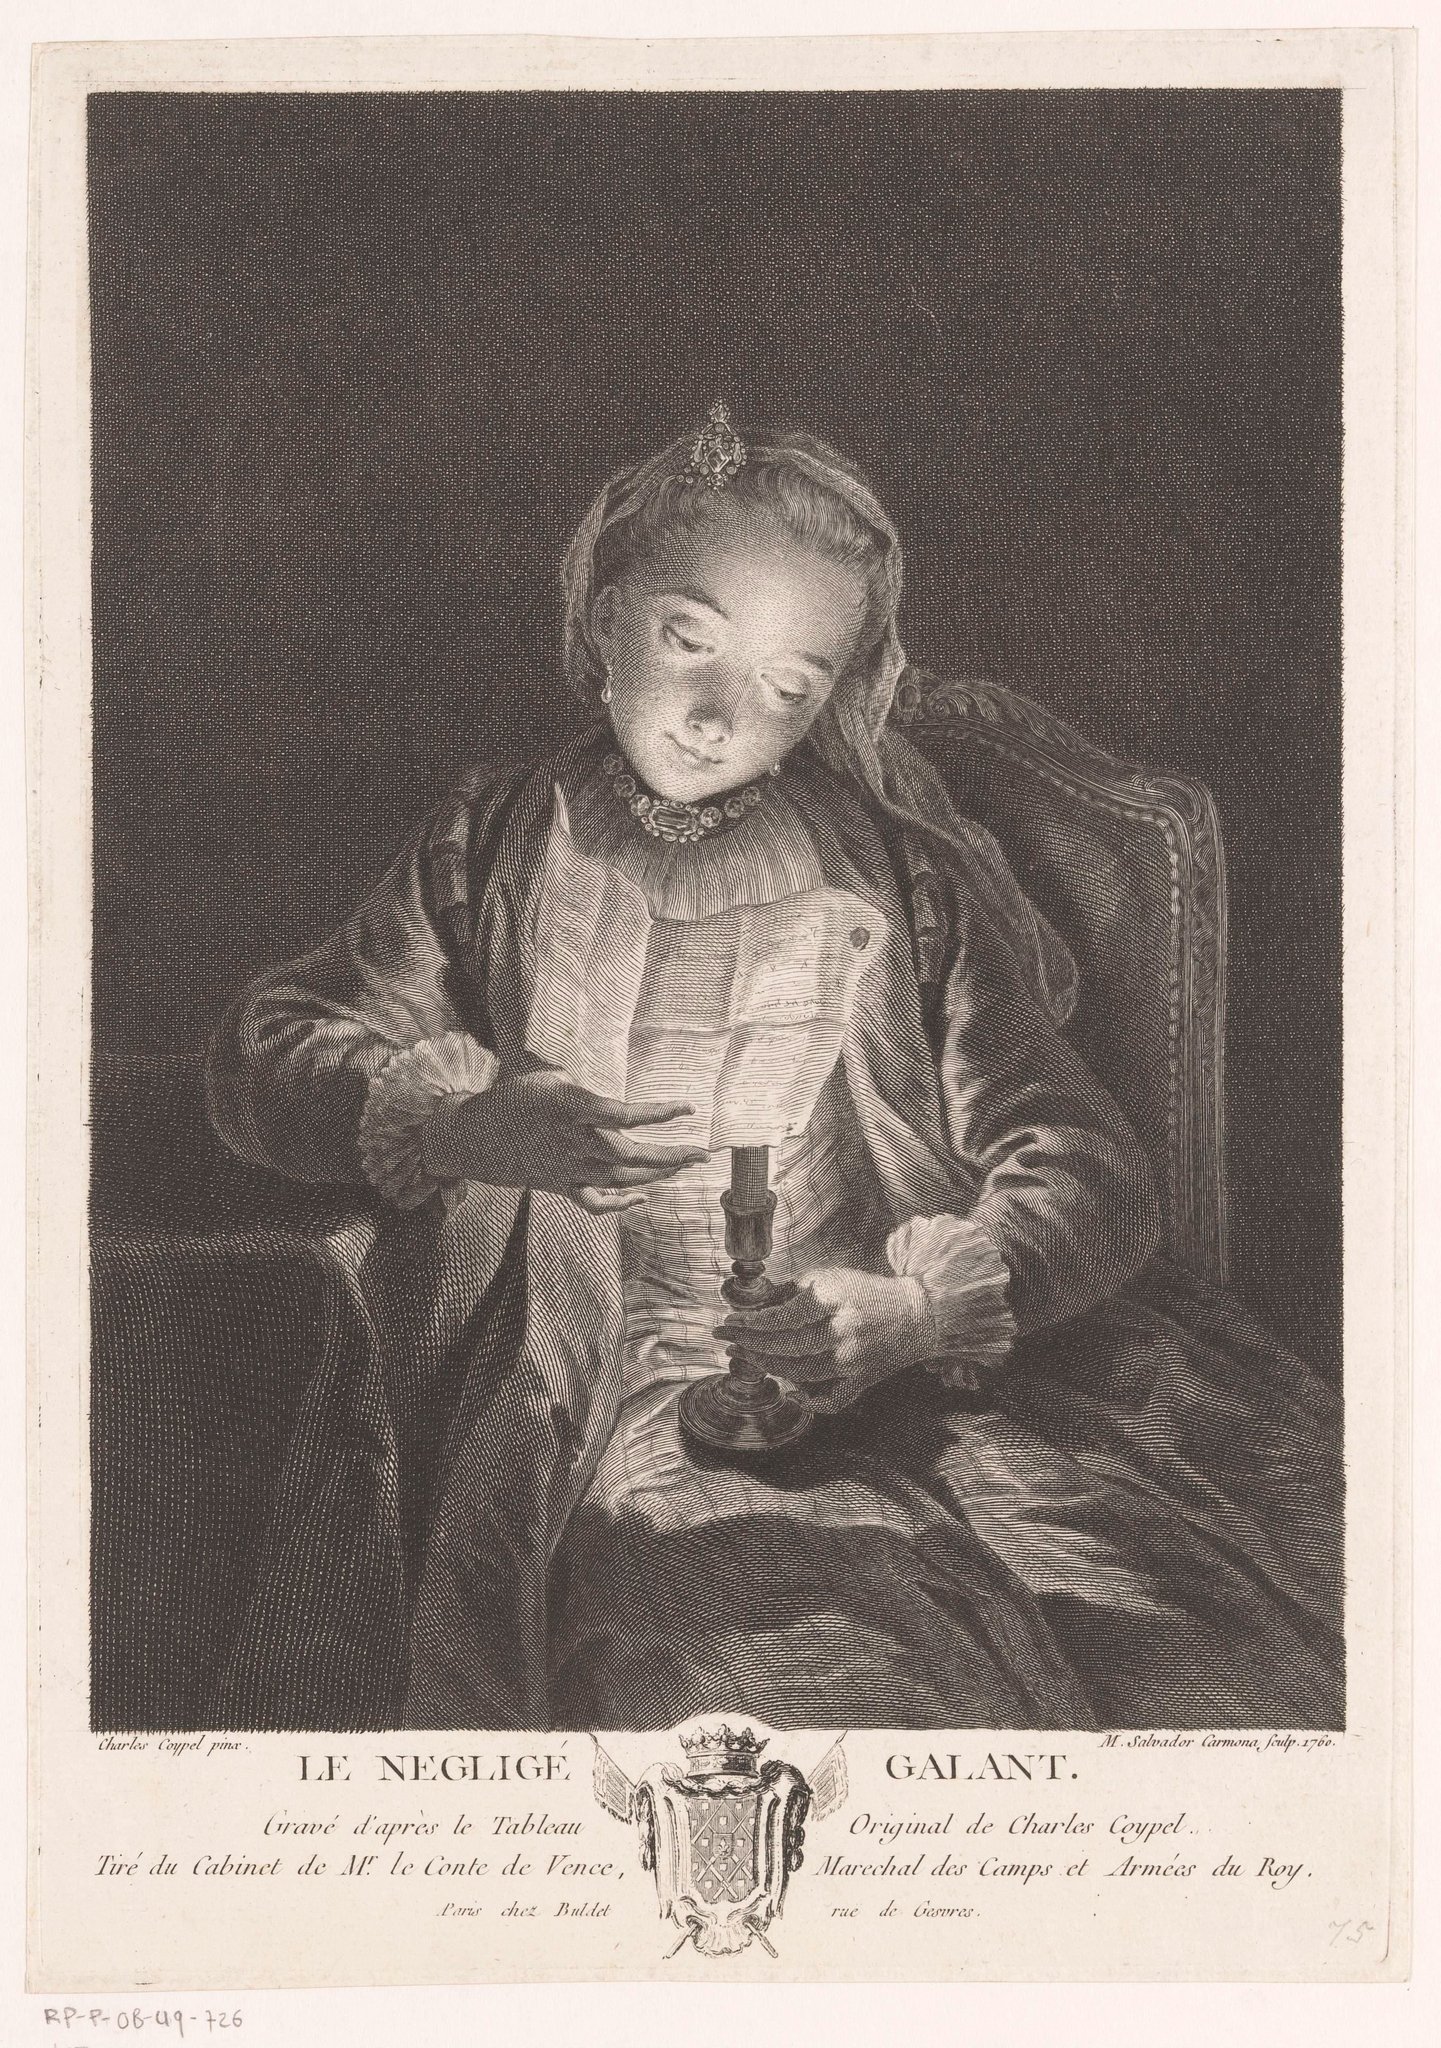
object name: print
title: Le negligé galant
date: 1760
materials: paper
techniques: engraving, etching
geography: spain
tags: candle, letter, envelope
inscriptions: collector's mark: Lugt 240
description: Onder de voorstelling de titel en een wapenschild.